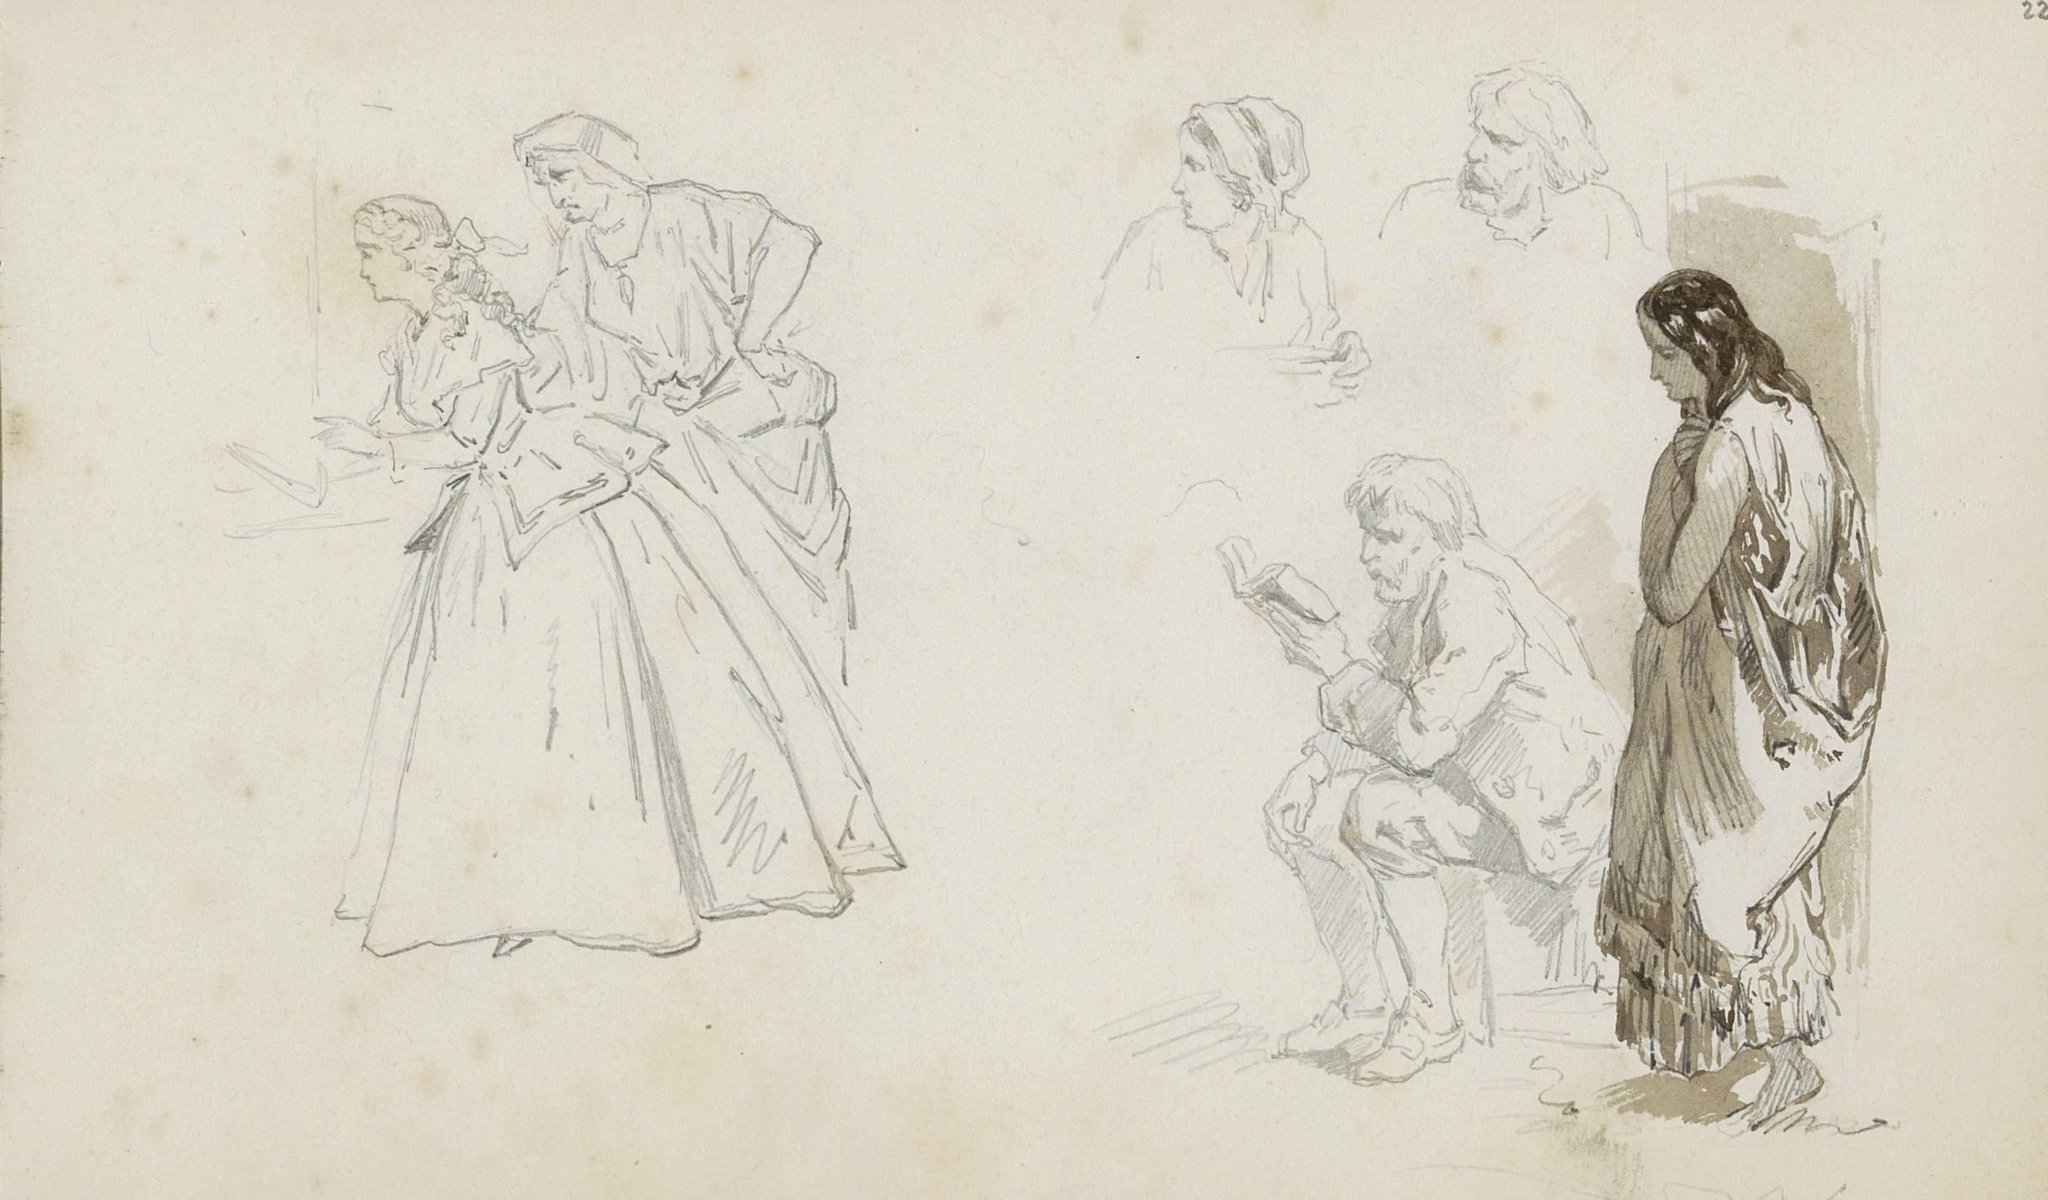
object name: sketchbook leaf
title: Figuurstudies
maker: charles rochussen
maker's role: draughtsman, painter, print maker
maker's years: 1814-1894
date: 1840-1860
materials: paper, pencil, watercolor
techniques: brush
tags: head (human), reading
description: Onder andere studies van een zittende lezende man en een vrouw met een omslagdoek. Blad 22 recto uit een schetsboek met 38 bladen.